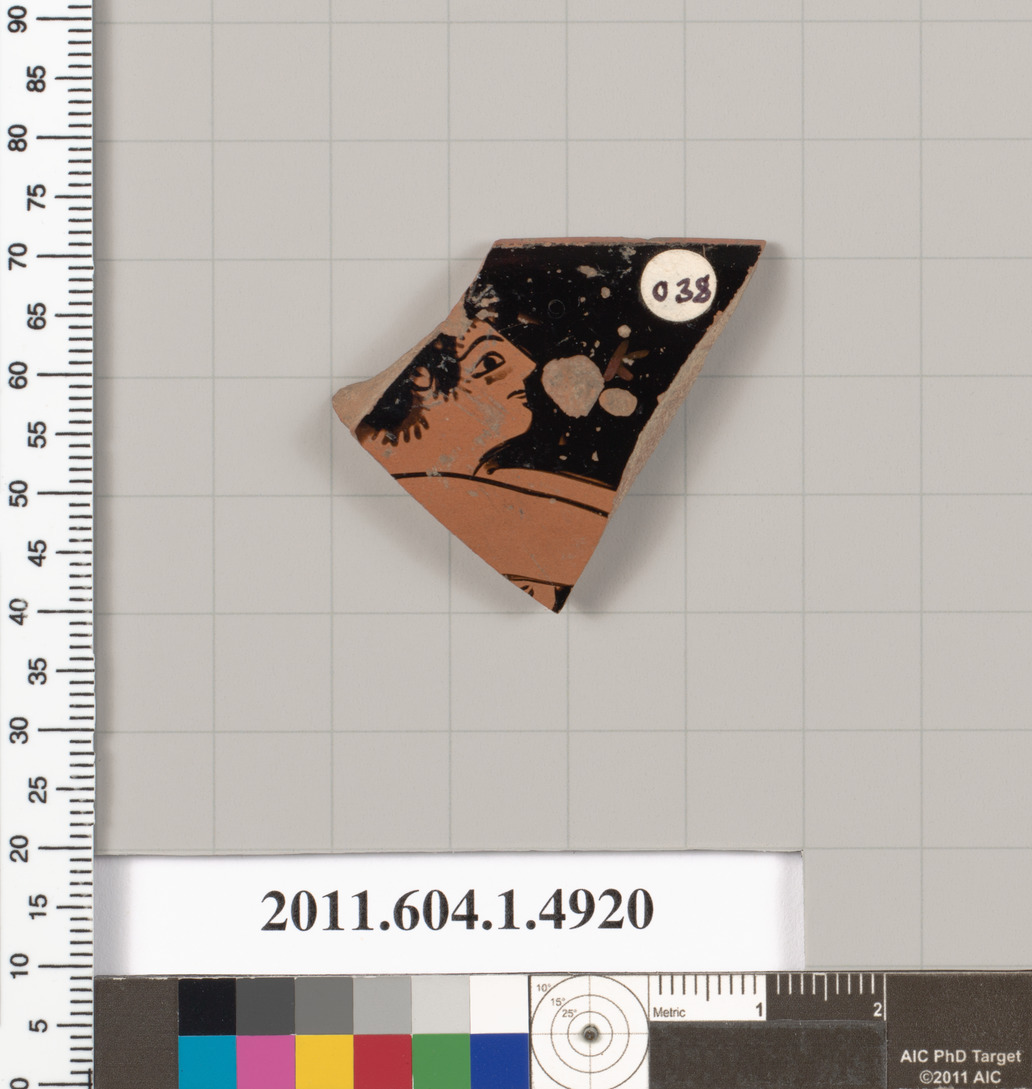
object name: kylix fragment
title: Terracotta rim fragment of a kylix (drinking cup)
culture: greek, attic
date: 520-500 BCE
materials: terracotta